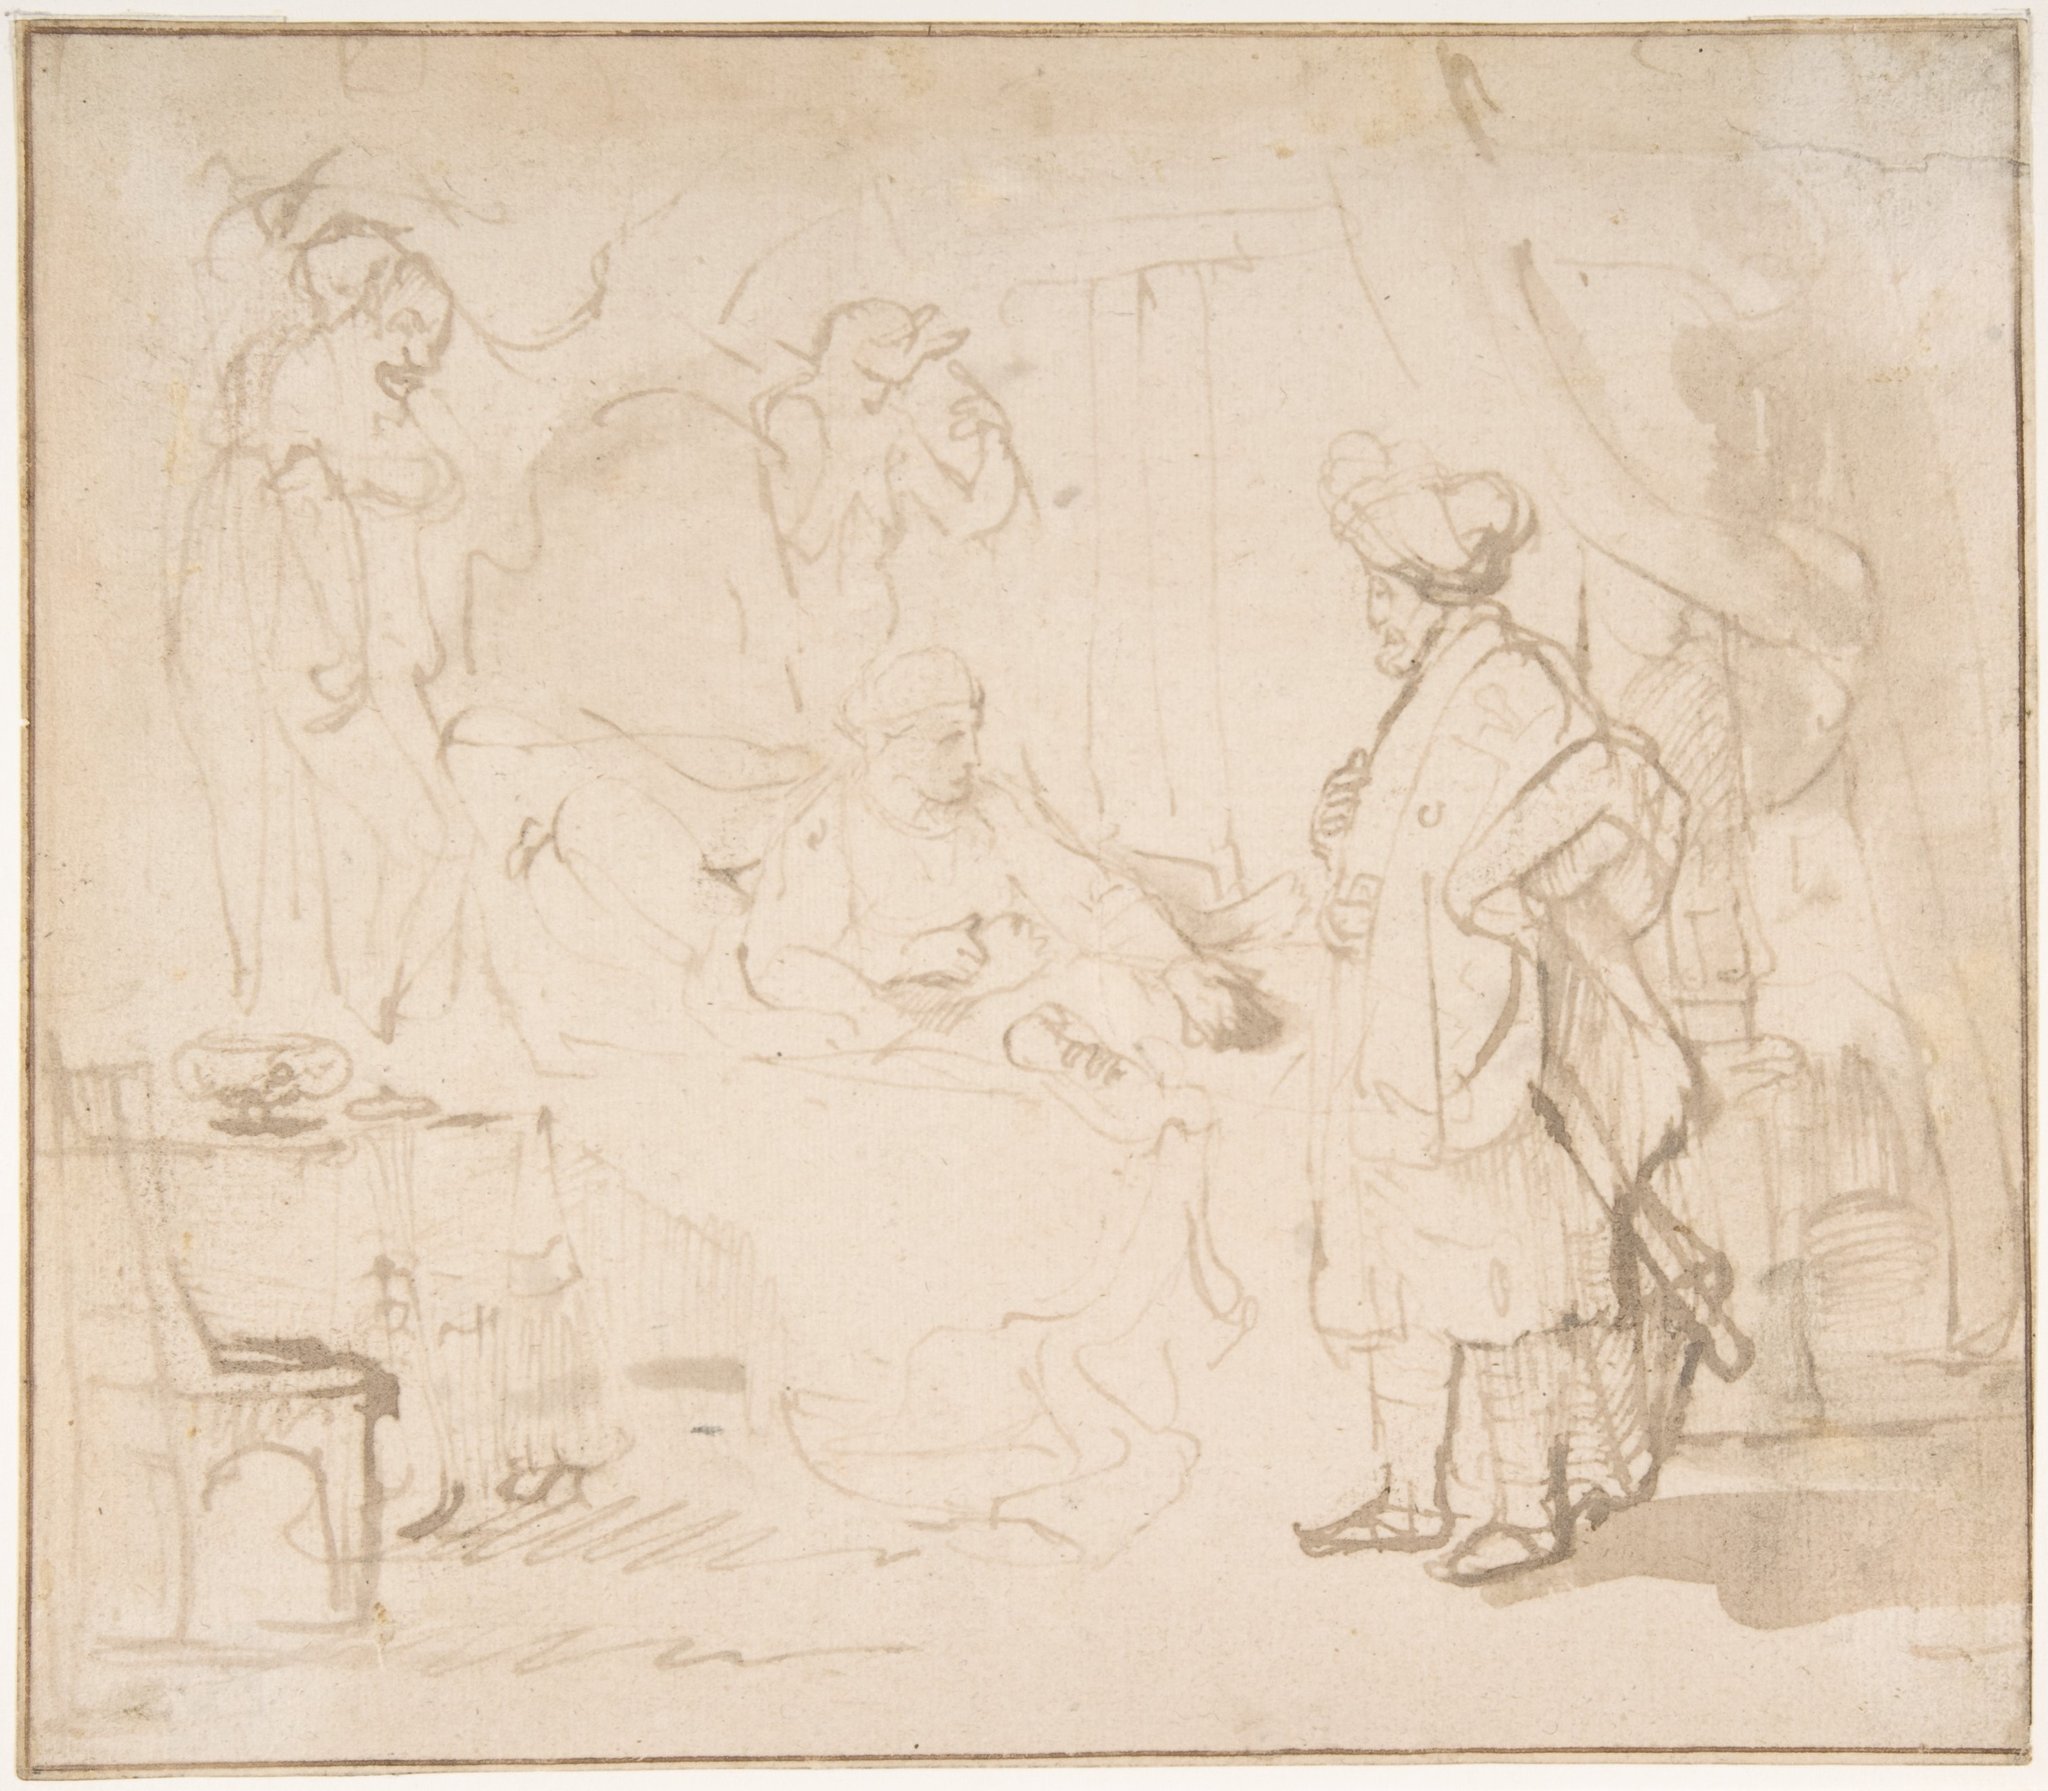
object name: drawing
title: Potiphar's Wife Accusing Joseph Before her Husband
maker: rembrandt van rijn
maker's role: artist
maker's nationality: dutch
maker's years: 1606-1669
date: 1620-1669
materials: ink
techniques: brush, pen, wash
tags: men,women,chairs